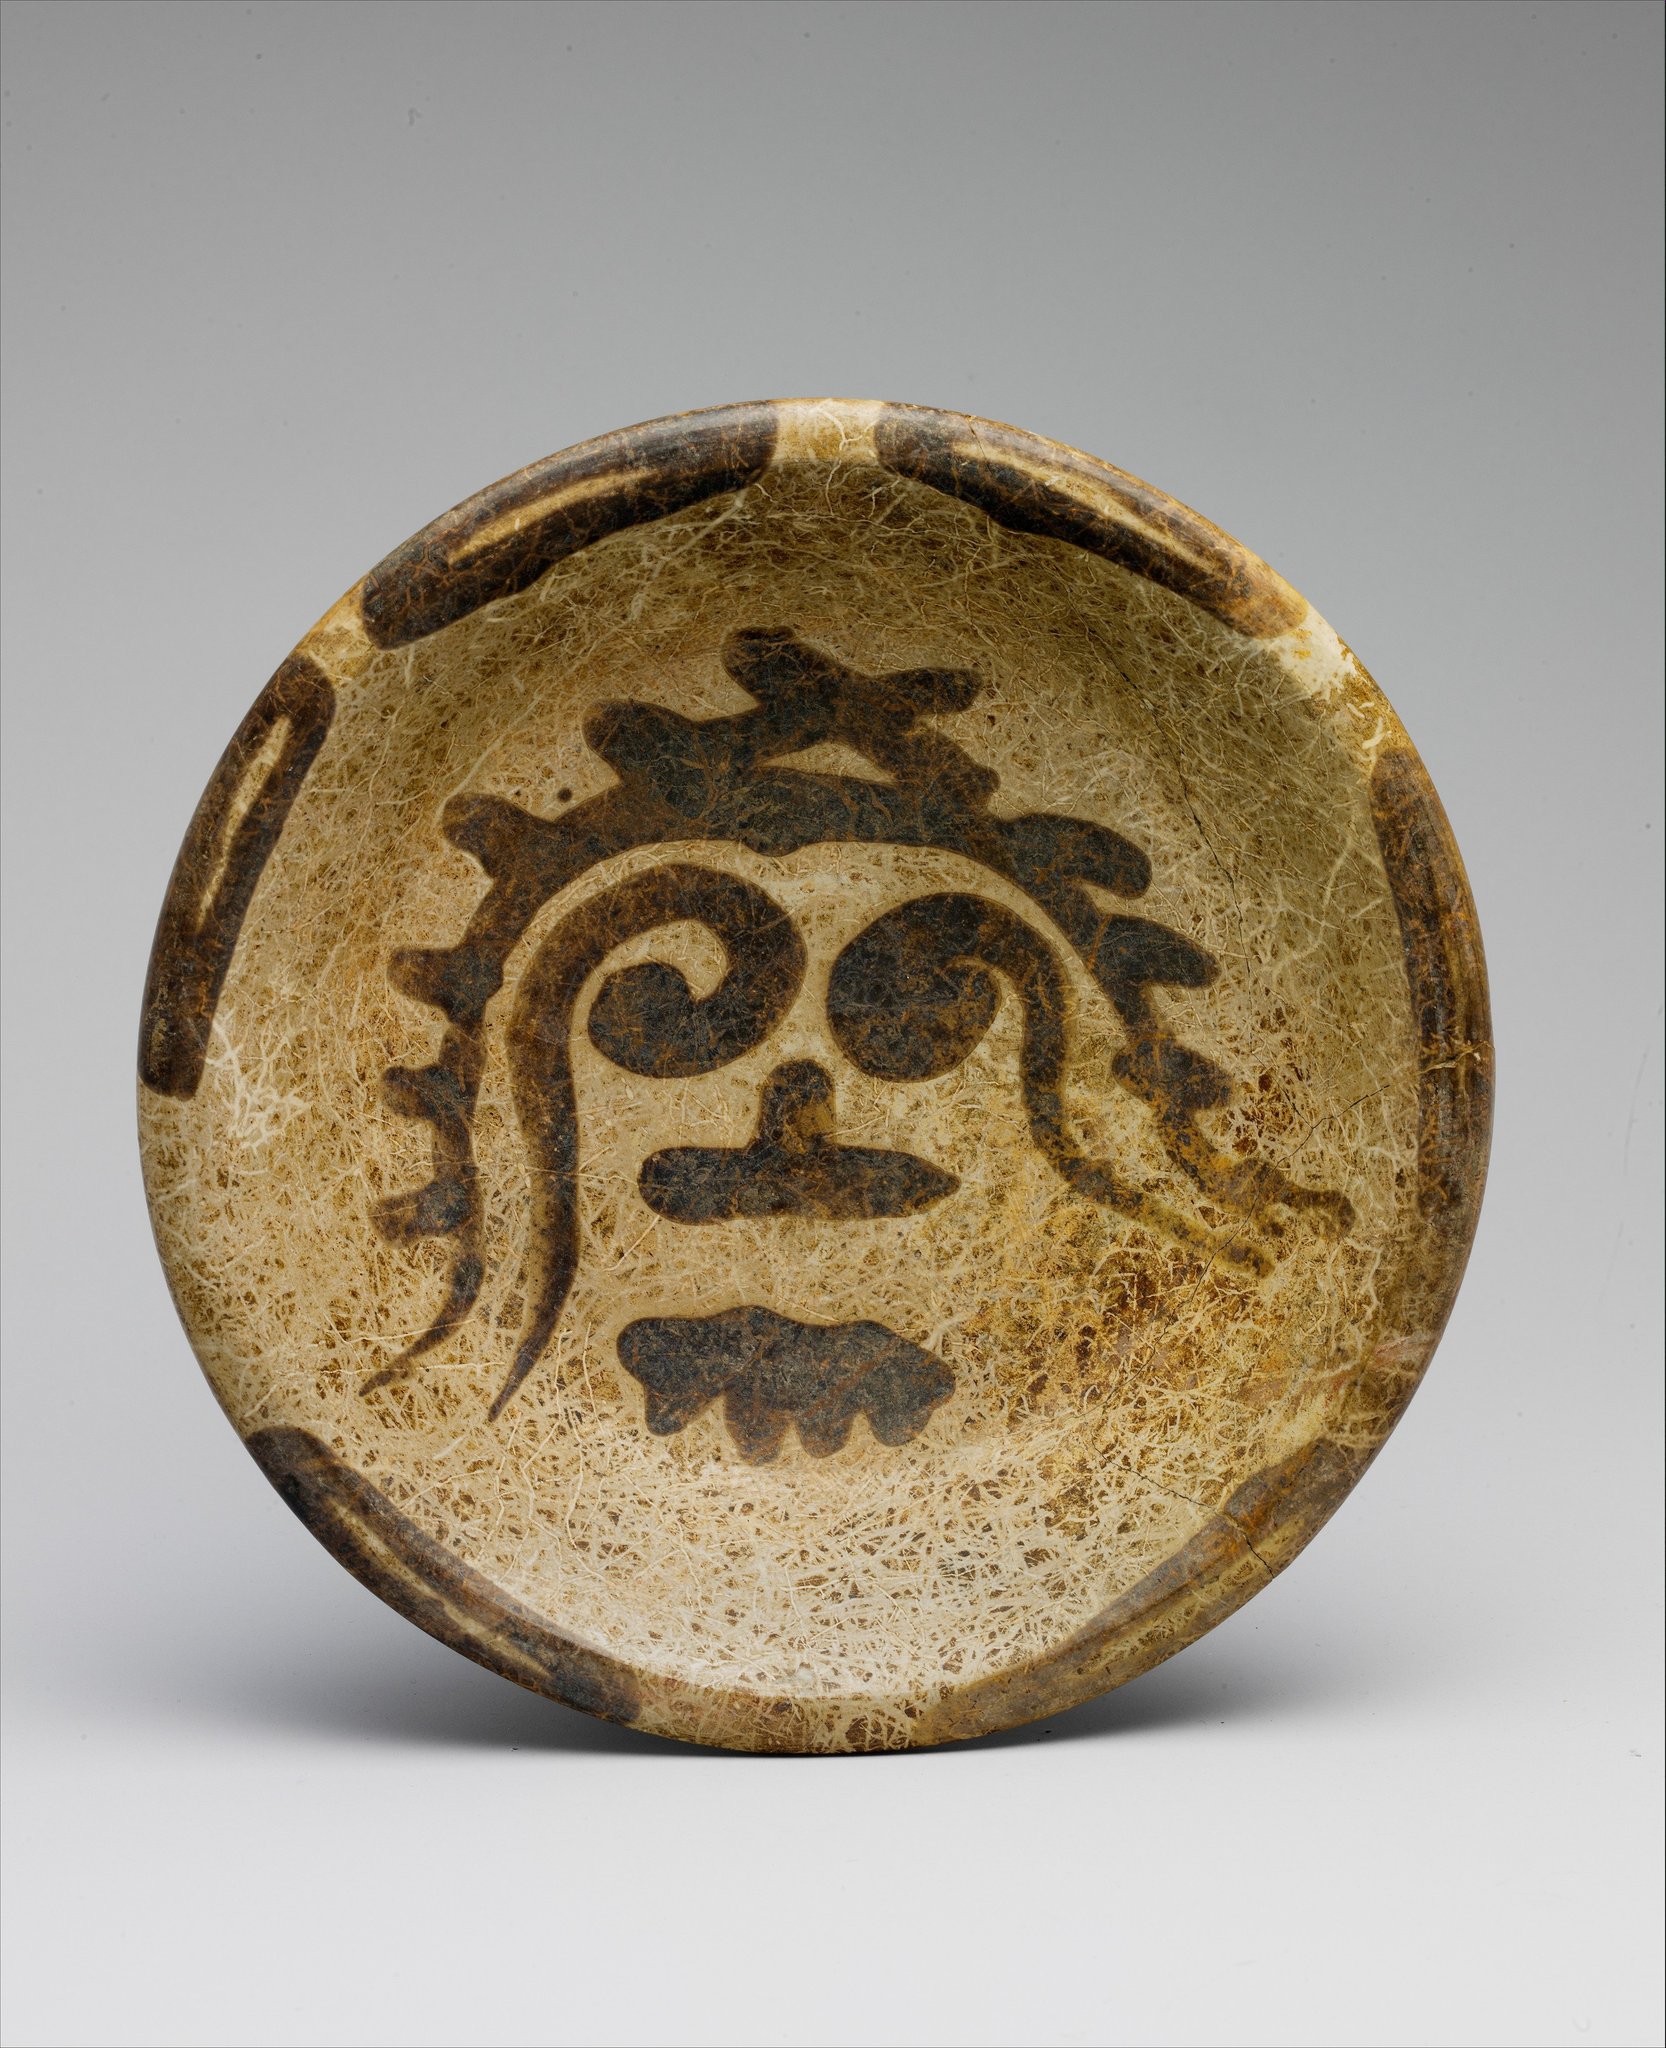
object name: plate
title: Tripod Plate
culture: maya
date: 801-1000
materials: ceramic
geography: mexico